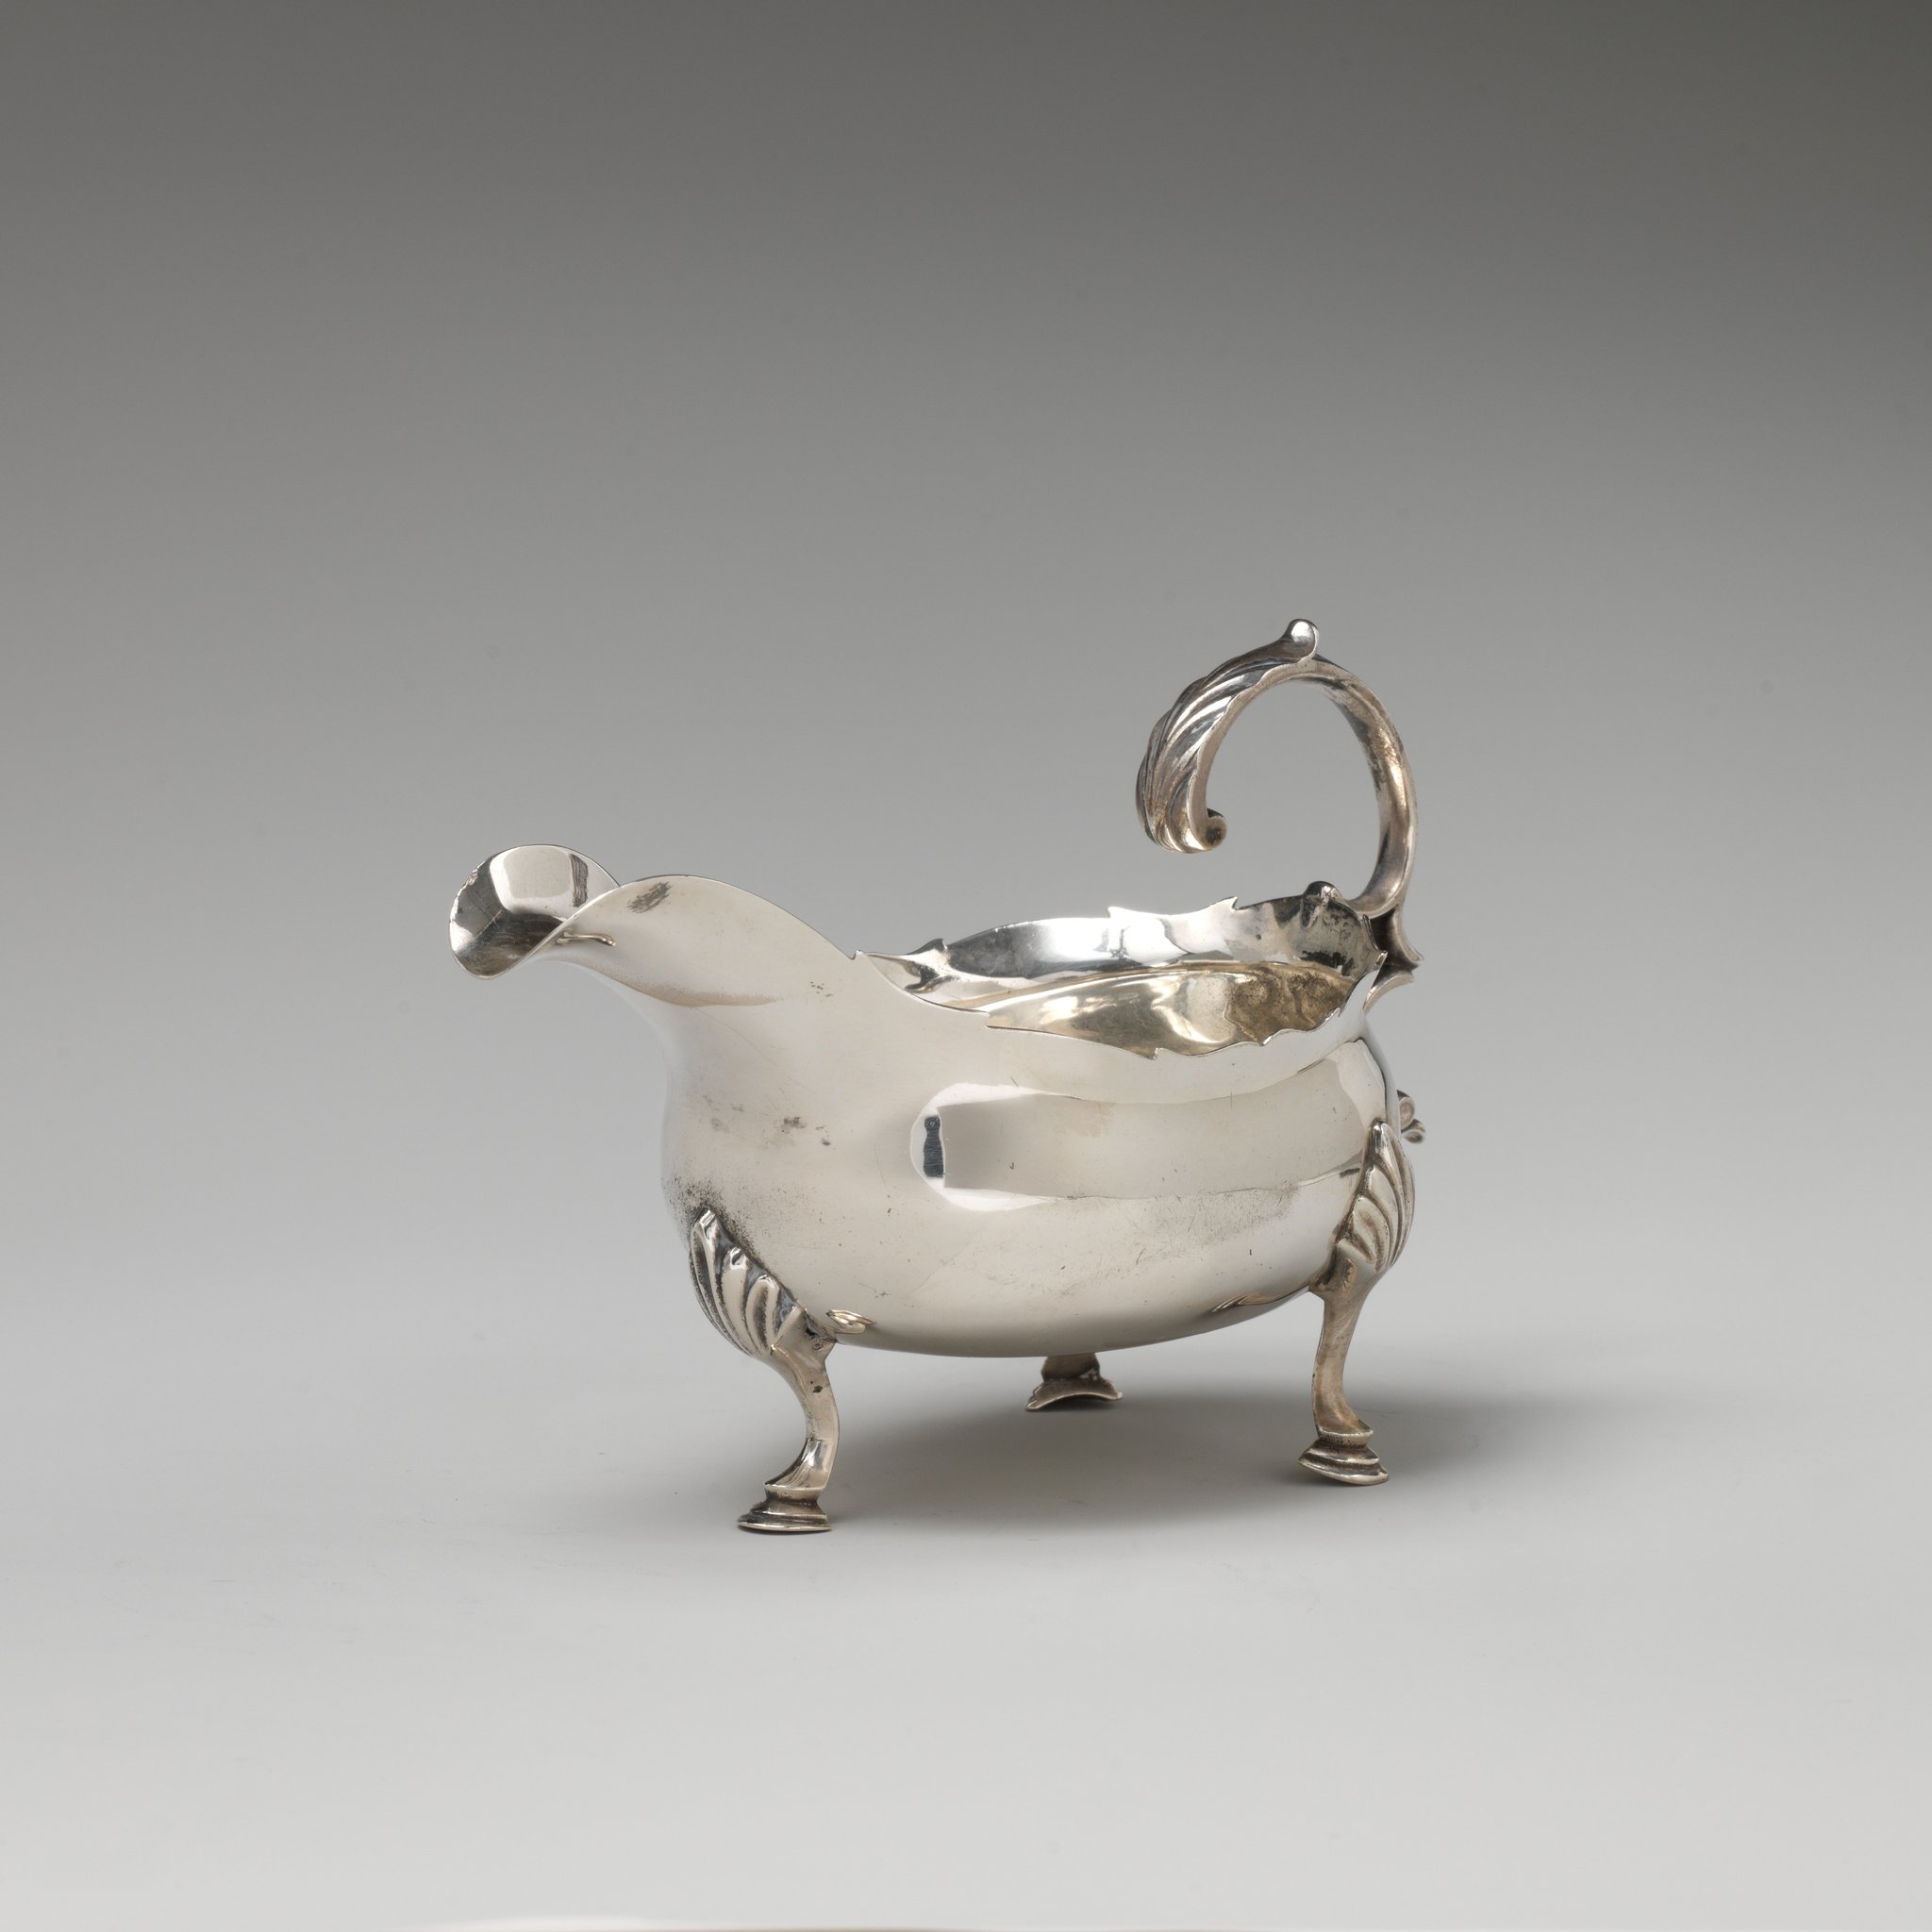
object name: sauceboat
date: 1771-1772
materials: silver